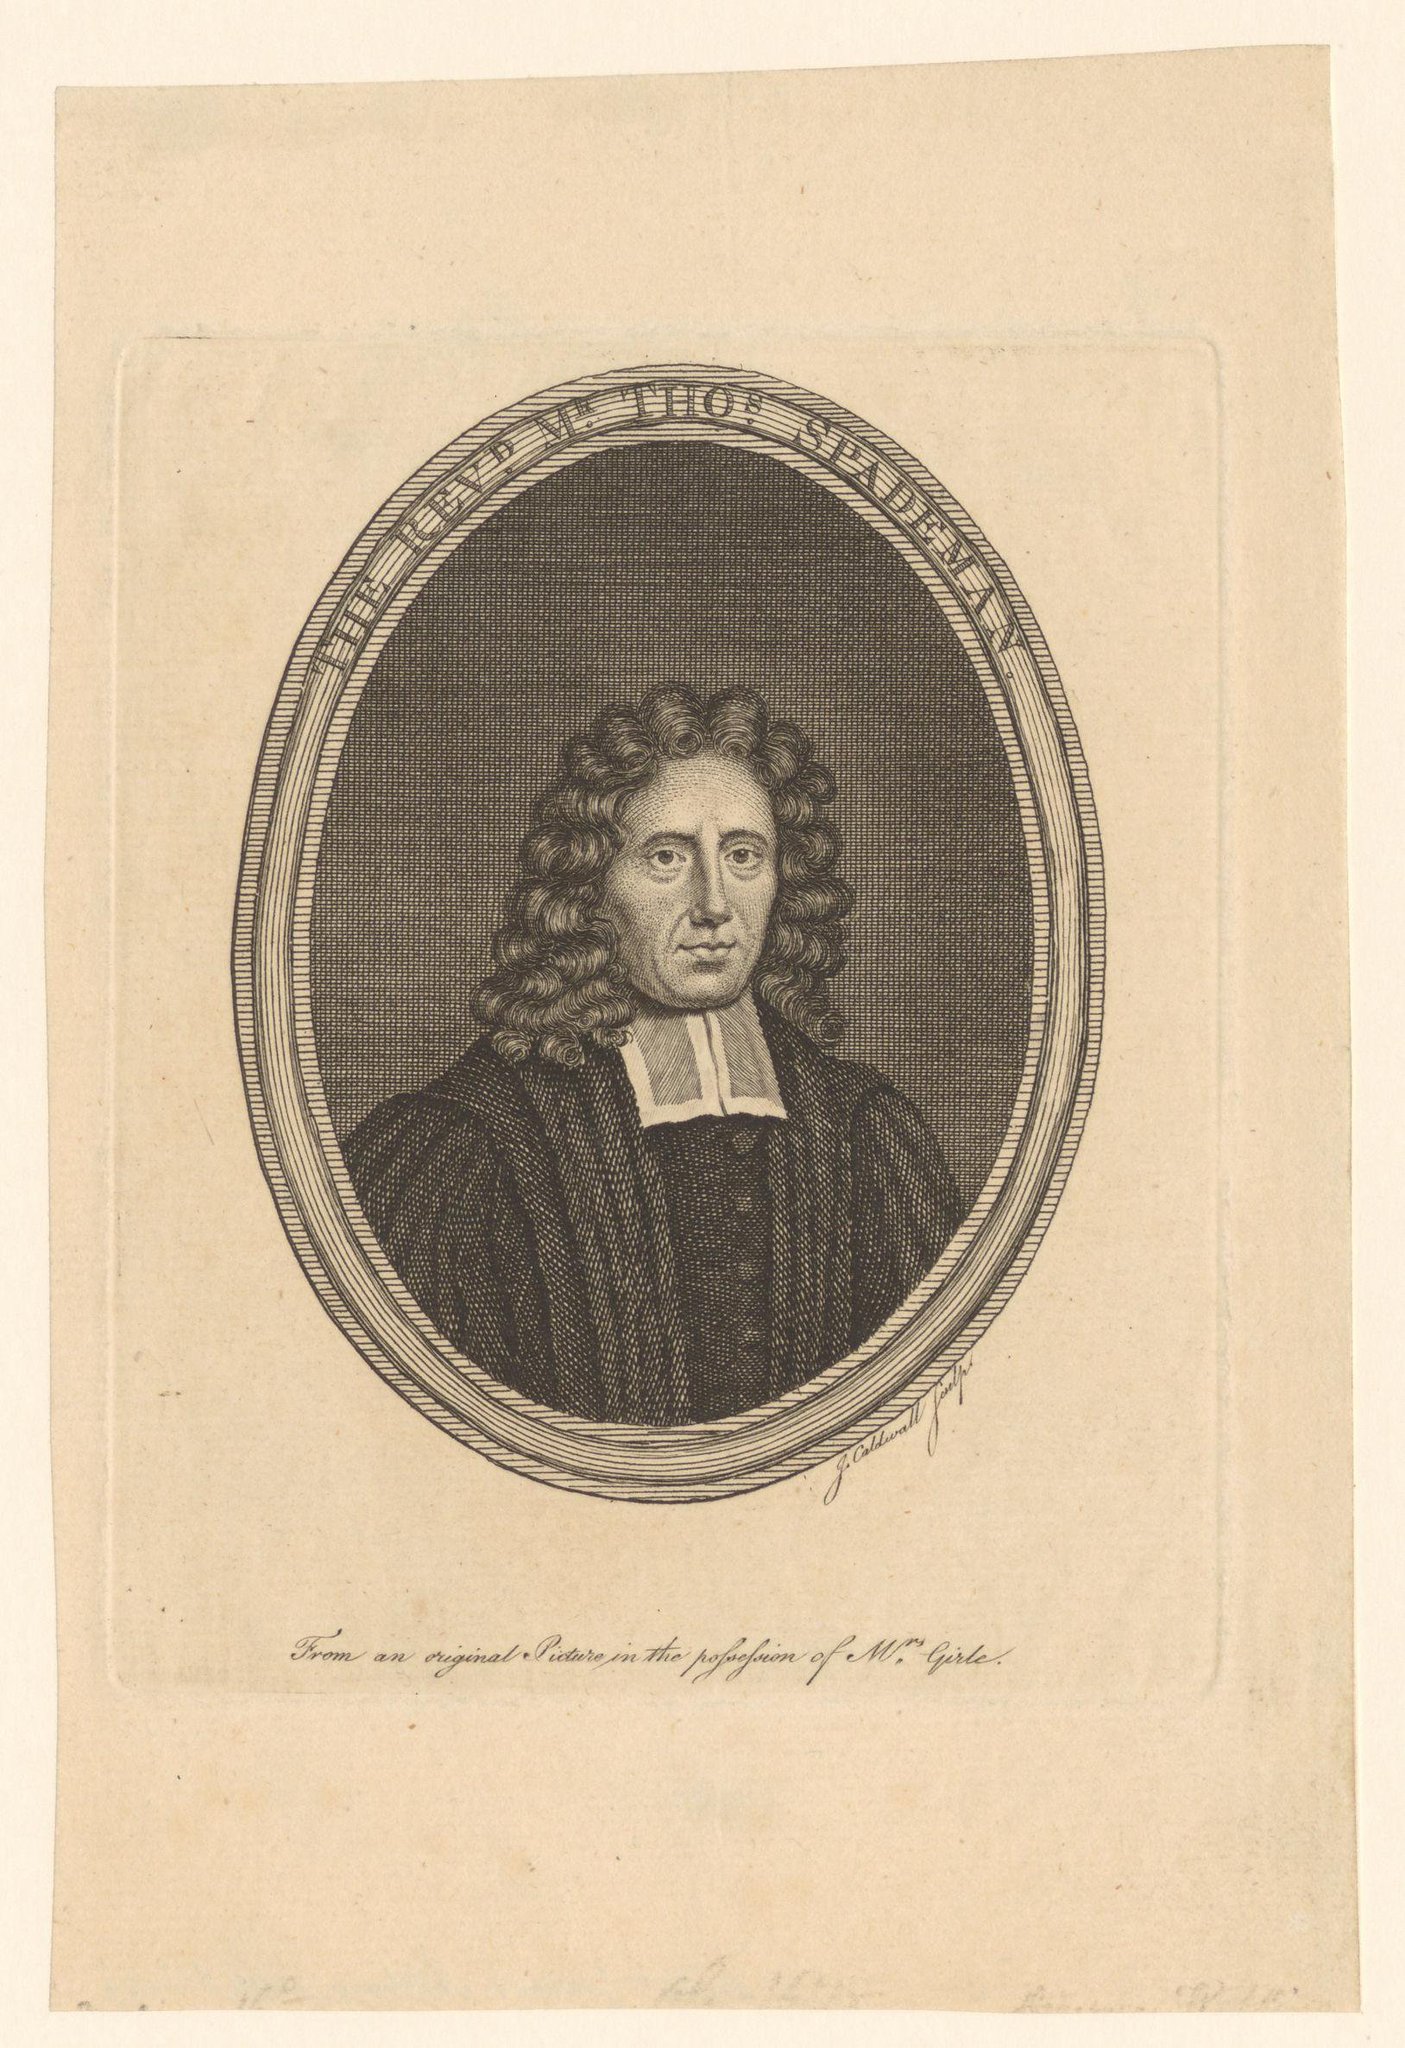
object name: print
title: The Rev.d Mr. Tho.s Spademan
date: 1759-1800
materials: paper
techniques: etching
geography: england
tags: clergyman, historical persons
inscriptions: collector's mark: Lugt 2228